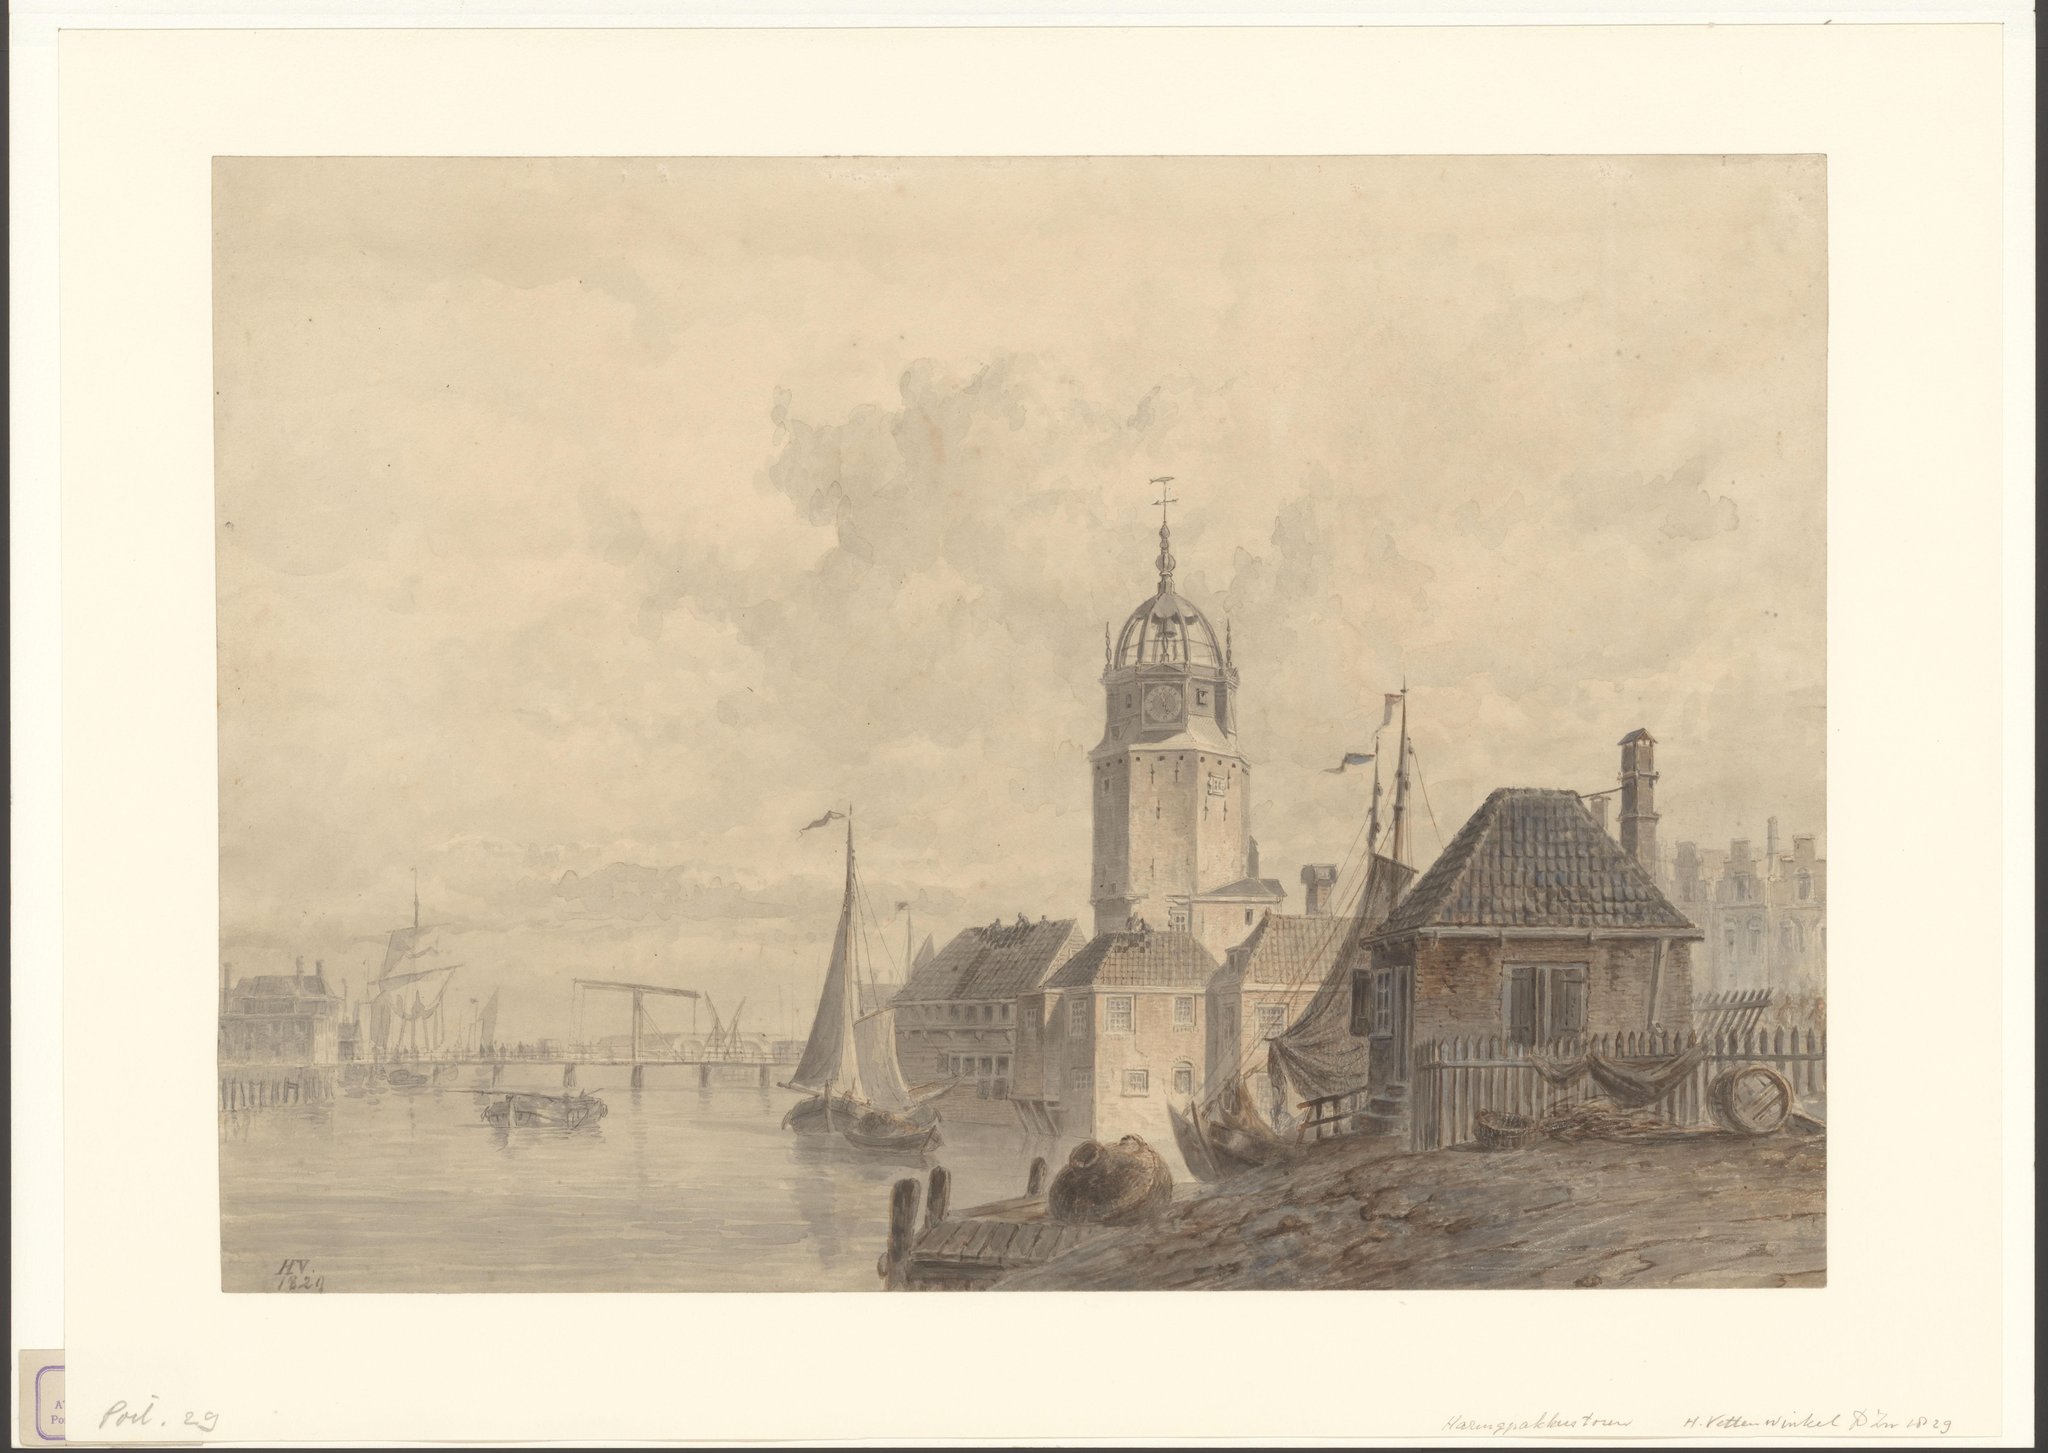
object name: drawing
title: Gezicht op de Haringpakkerstoren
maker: hendrik vettewinkel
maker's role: draughtsman, painter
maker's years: 1809-1878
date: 1829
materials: ink, paper, pencil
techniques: brush, pen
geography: amsterdam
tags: tower, clock tower ~ monumental adornment, city-view in general; 'veduta', river, bridge in city across river, canal, etc.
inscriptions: signature and date: ‘Hk Vettewinkel dz. 1829’, inscription: ‘De Haringpakkers toren (...) aan het sloopen.’, collector's mark: ‘29’ Lugt 1641b, inscription: ‘Port. 29 / Haringpakkerstoren / H. Vettenwinkel D Zn 1829’, signature and date: ‘HV. / 1829’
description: Onderwerpsrubriek binnen de Atlas Amsterdam: Haringpakkerstoren.